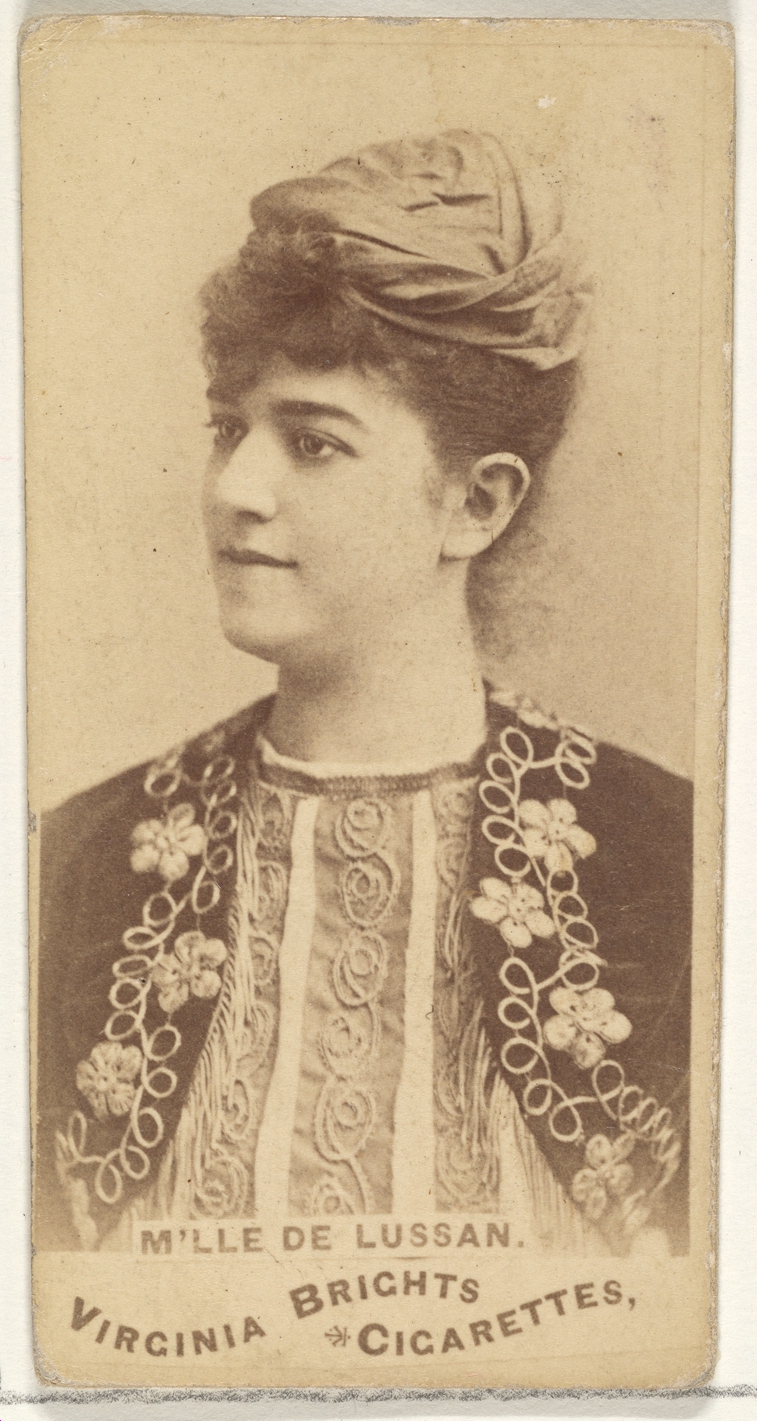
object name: photograph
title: Mlle. de Lussan, from the Actors and Actresses series (N45, Type 1) for Virginia Brights Cigarettes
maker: allen & ginter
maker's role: publisher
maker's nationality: american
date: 1888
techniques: albumen silver print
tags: portraits,women,actresses